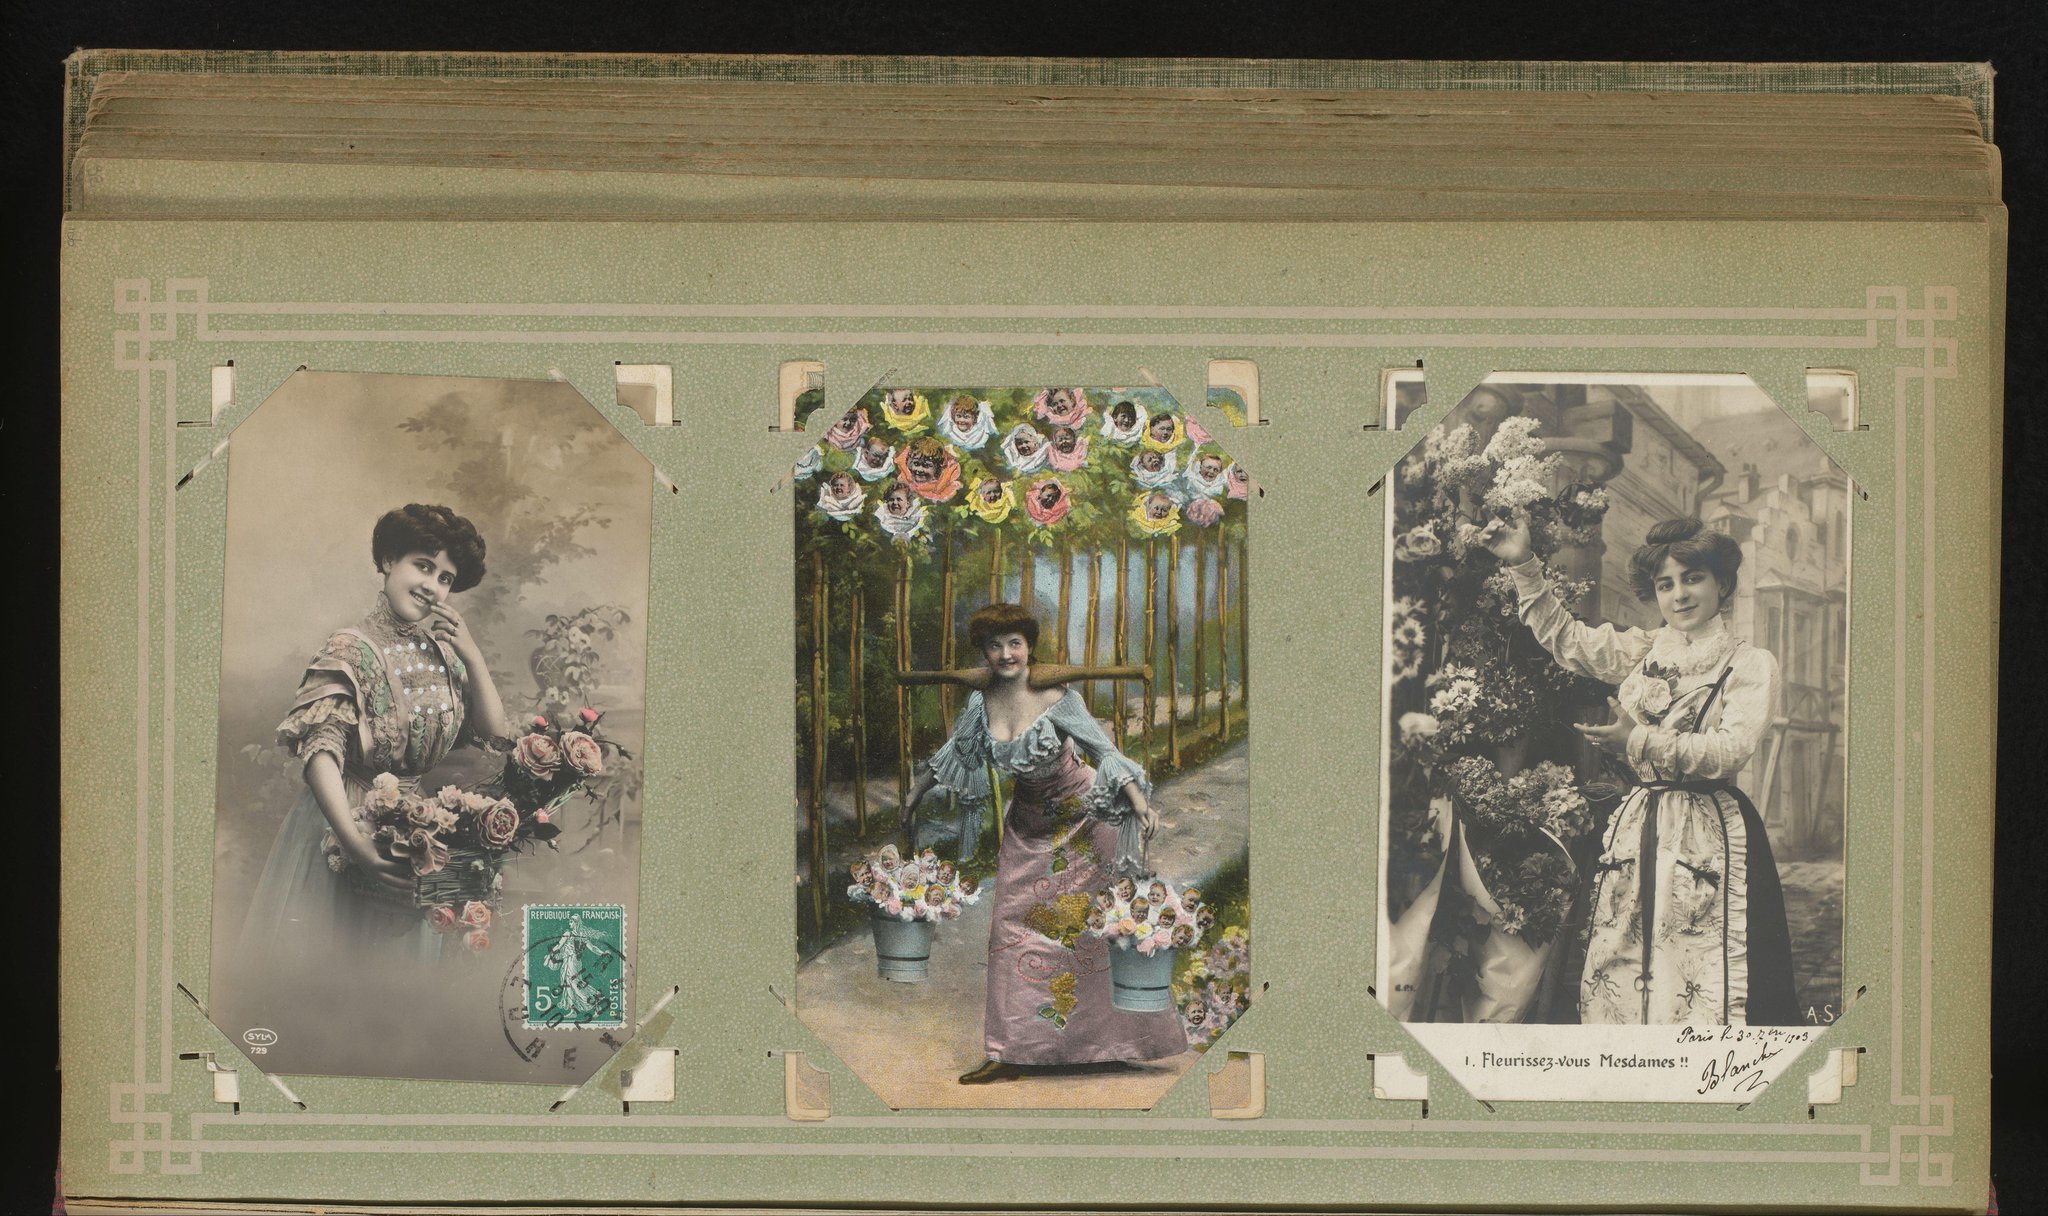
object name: photomechanical print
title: Drie portretten van vrouwen met bloemen, waarvan één met bloemen met kinderhoofden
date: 1900-1930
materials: cardboard, ink, photographic support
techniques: gelatin silver print, hand coloring, pen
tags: flowers, historical persons - bb - woman, infant, baby ~ the ages of man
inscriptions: monogram: ‘A.S.’, monogram: ‘SYLA’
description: Deze foto's en prent maken deel uit van een album.